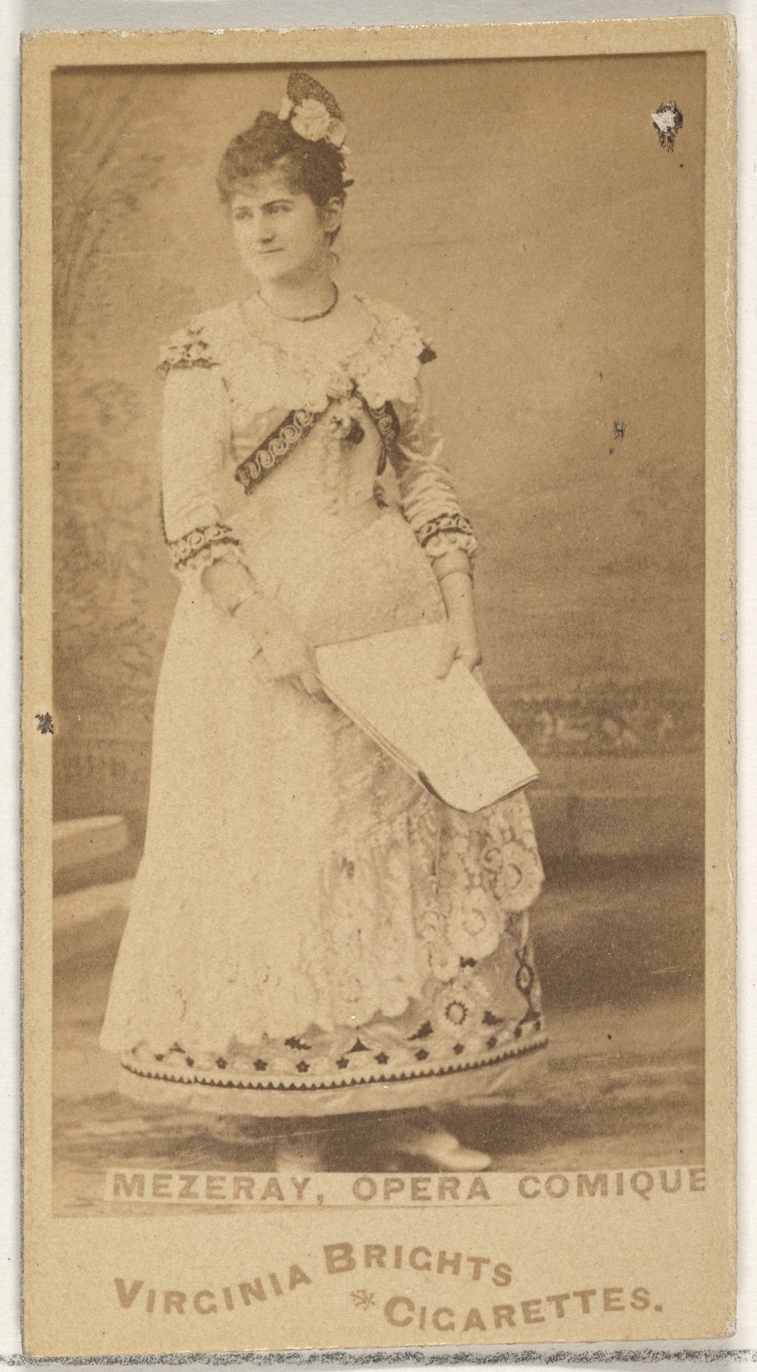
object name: photograph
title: Mezeray, Opera Comique, from the Actors and Actresses series (N45, Type 1) for Virginia Brights Cigarettes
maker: allen & ginter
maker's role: publisher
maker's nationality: american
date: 1888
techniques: albumen silver print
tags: portraits,women,actresses